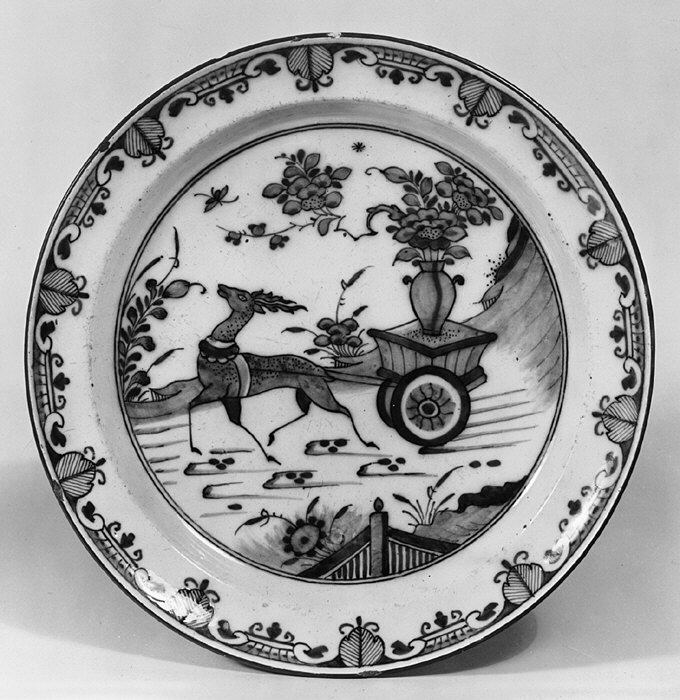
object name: plate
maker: the "greek a" factory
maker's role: manufactory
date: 1750-1775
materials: earthenware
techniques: glazing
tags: deer,flowers